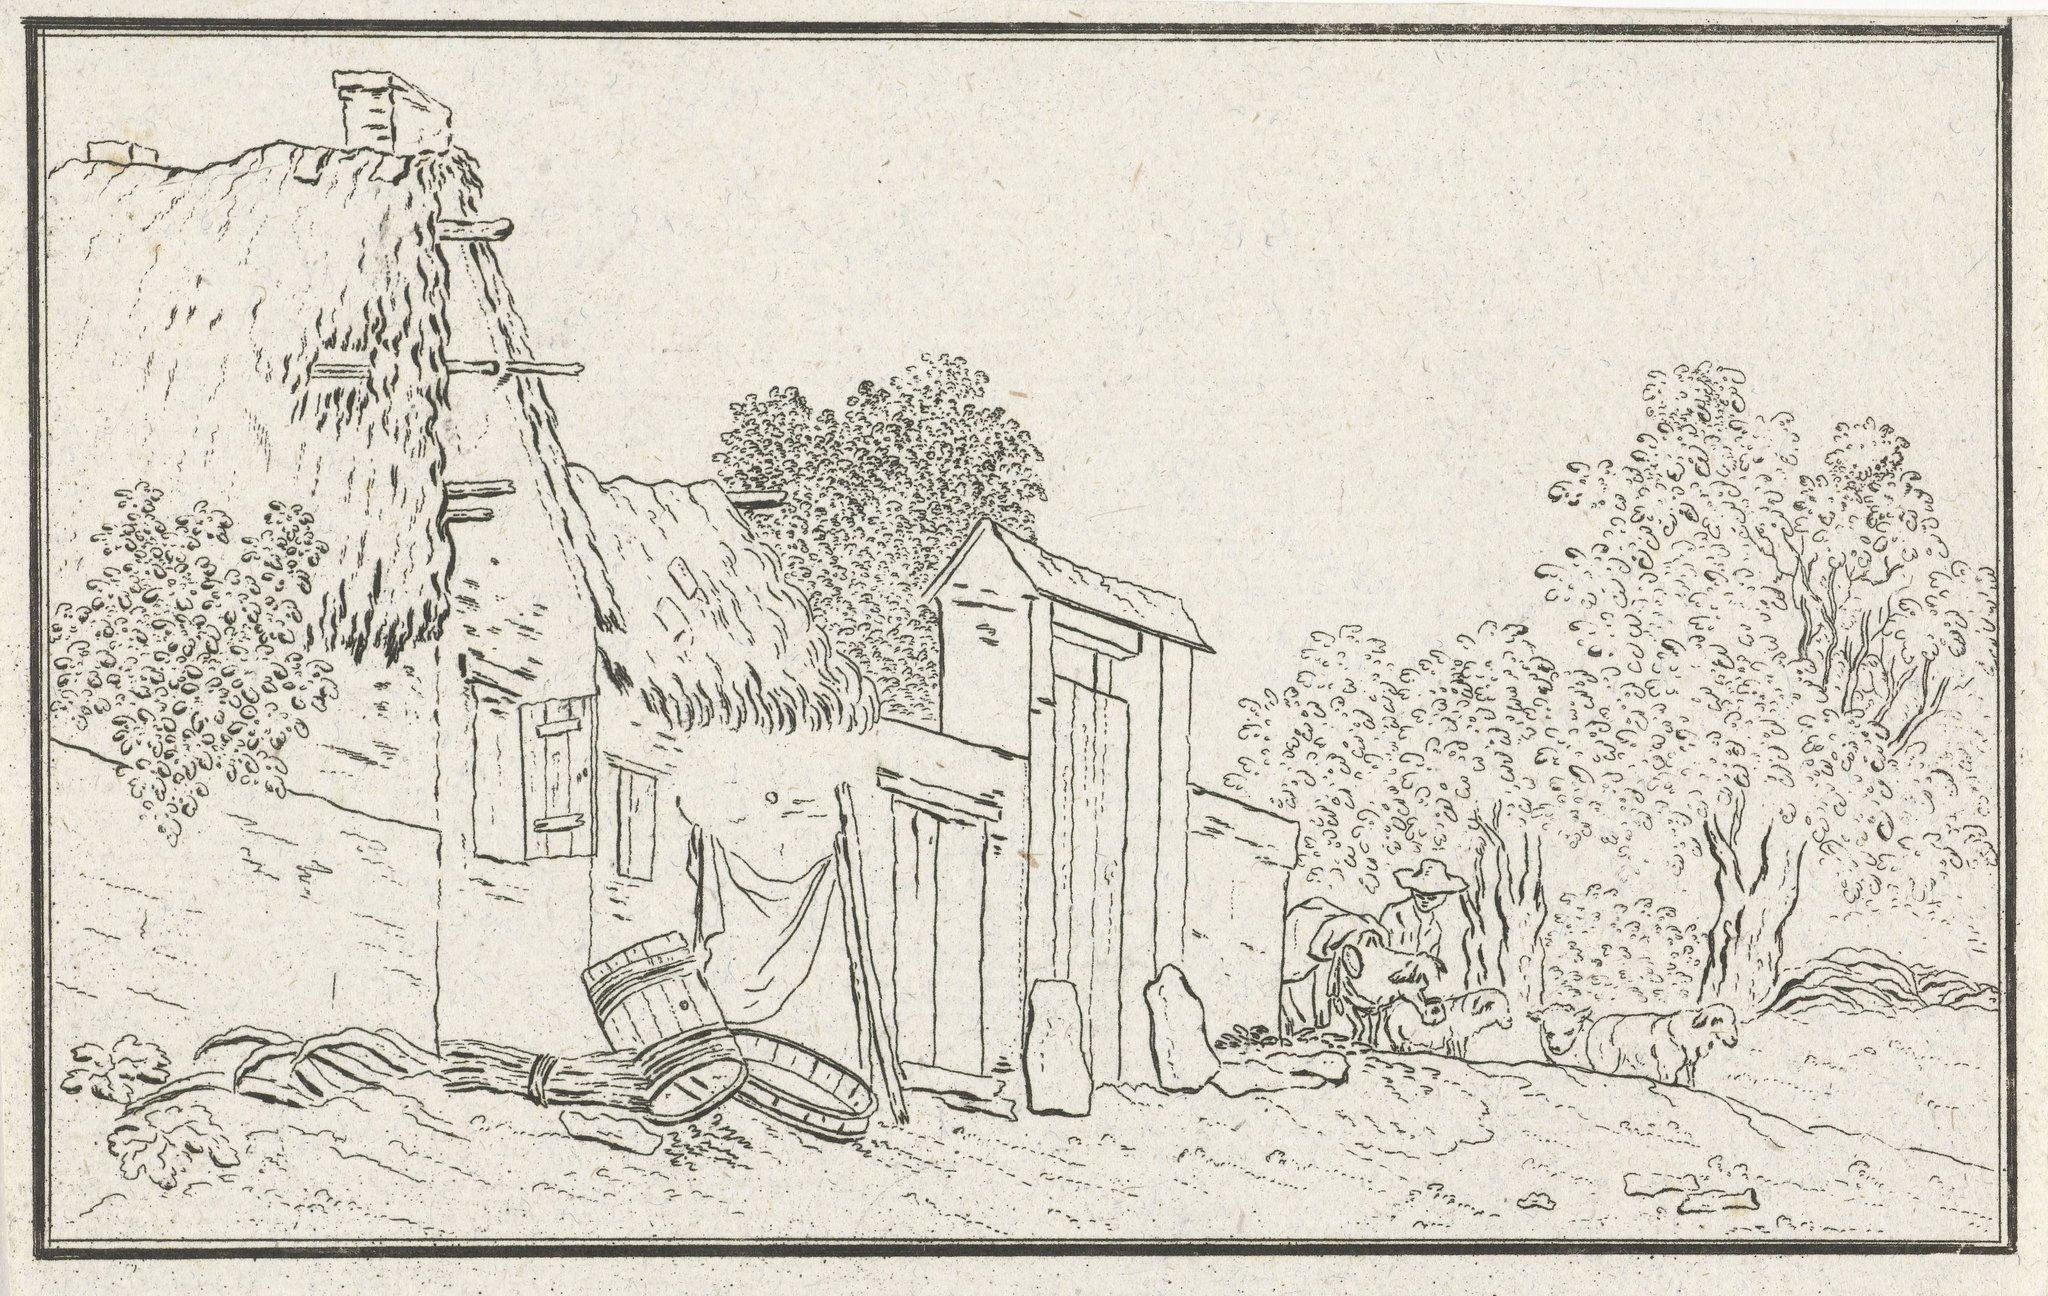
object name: print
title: Landschap met boerderij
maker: christian friedrich fritzsch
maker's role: print maker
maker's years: 1719-1774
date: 1729-1774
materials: paper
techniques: etching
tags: farm or solitary house in landscape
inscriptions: collector's mark: Lugt 2228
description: Gezicht op een boerderij waarvan rechts een boer met drie schapen en een koe loopt.